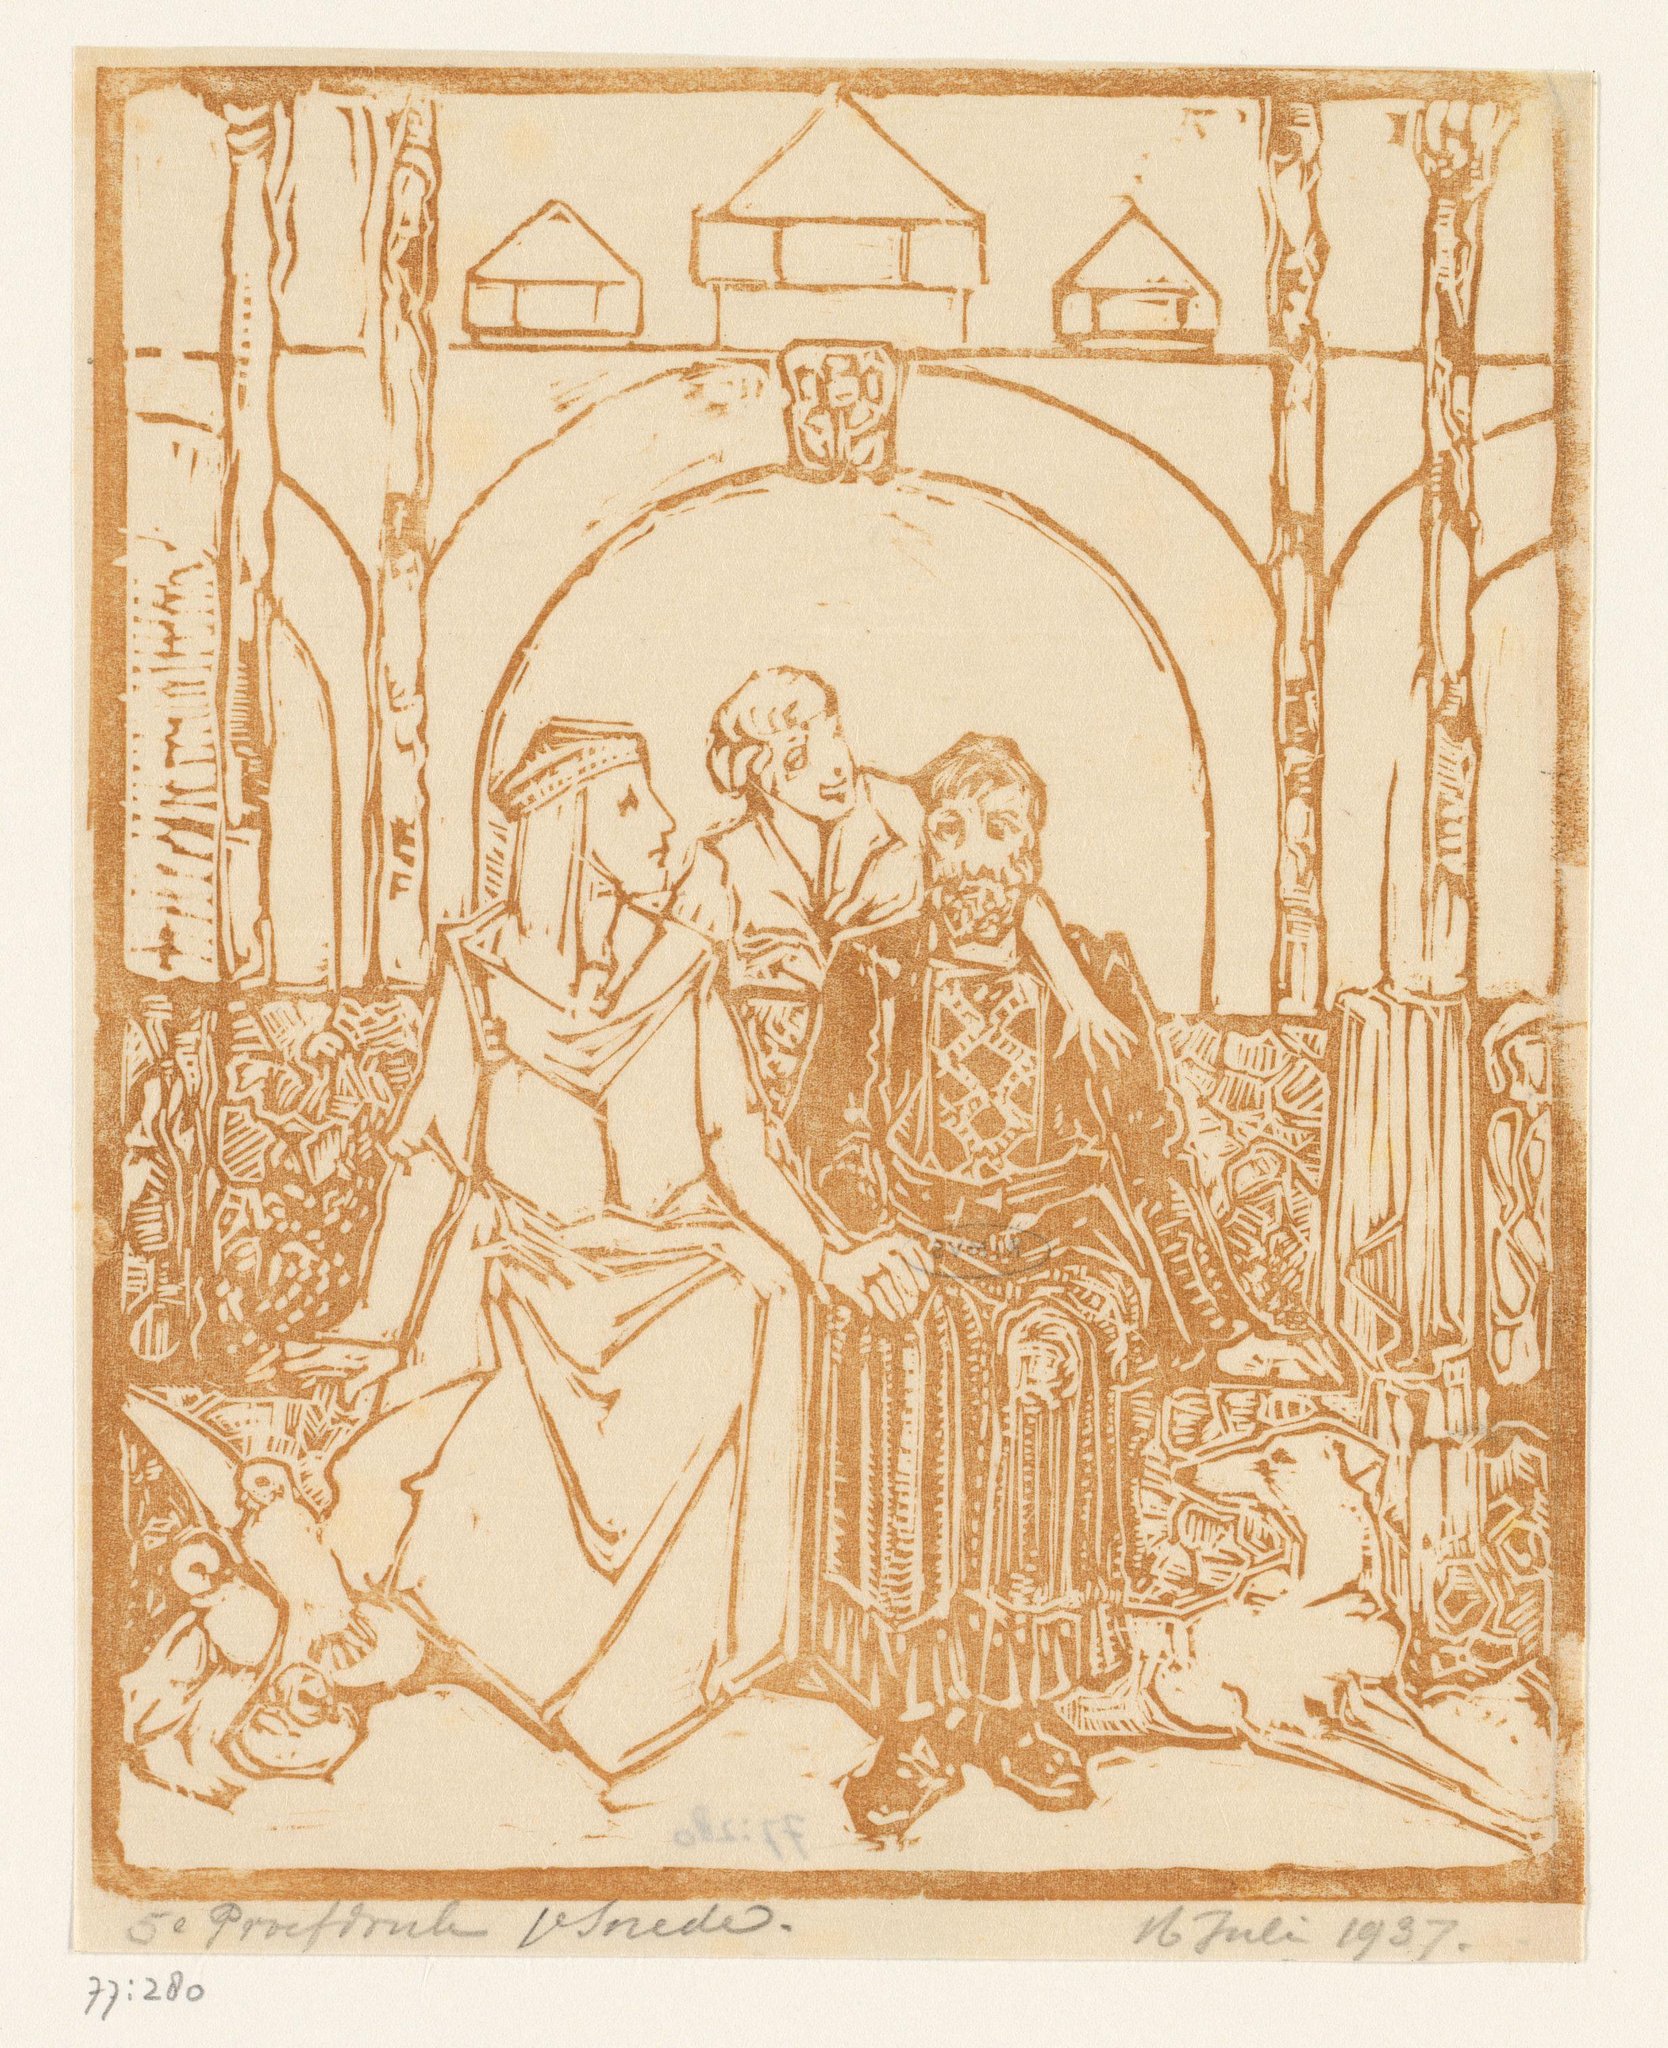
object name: print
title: Zittend paar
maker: bernard willem wierink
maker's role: draughtsman, print maker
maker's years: 1856-1939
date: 1937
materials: paper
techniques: relief print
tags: other birds: dove, couple of lovers, dog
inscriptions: collector's mark: Lugt 2228, annotation: ‘5e proefdruk 1e snede’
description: Illustratie voor een uitgave van een onbekend toneelstuk. Deze prent is waarschijnlijk een plaatsnede, ook al wordt in de literatuur veelal gesproken over een houtsnede. Voor zover Wierink zijn prenten in hoogdruk zelf heeft omschreven, heeft hij altijd de term 'plaatsnede' gebruikt.